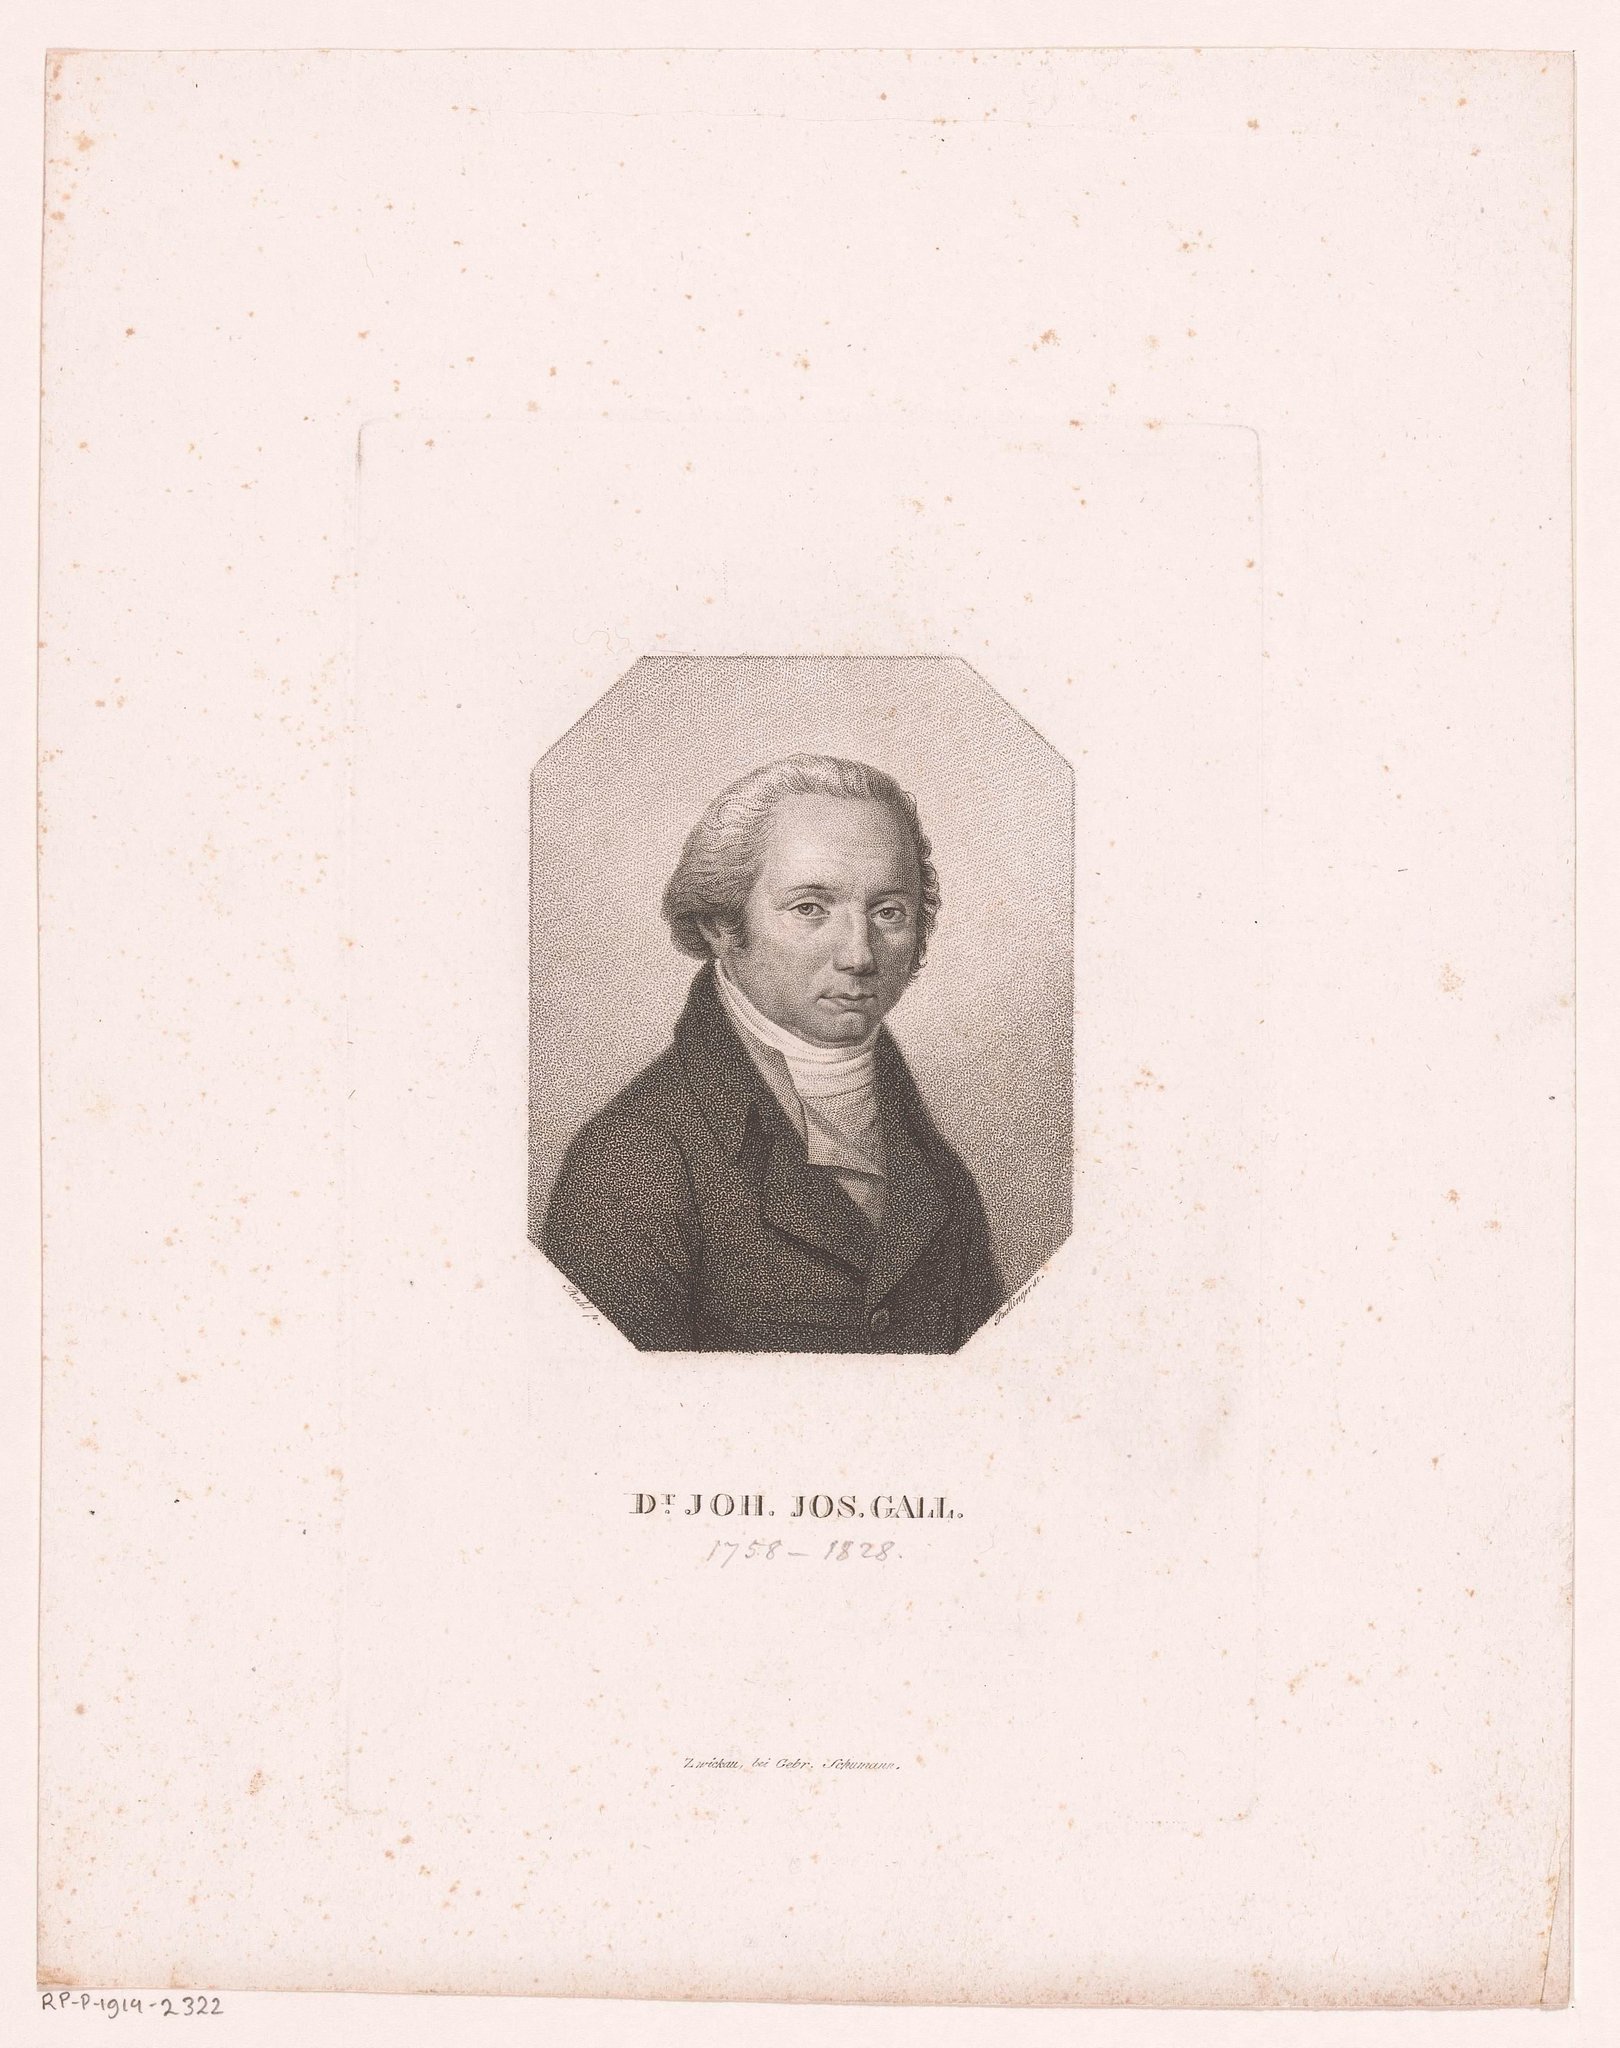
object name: print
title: Bildnisse der berühmtesten Menschen aller Völker und Zeiten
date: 1818-1832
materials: paper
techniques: stippling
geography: berlin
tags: historical persons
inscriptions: collector's mark: Lugt 2228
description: Prent gebruikt door de serie 'Bildnisse der berühmtesten Menschen aller Völker und Zeiten' van de gebroeders Schumann, uitgegeven in 1818-1832 te Zwickau.